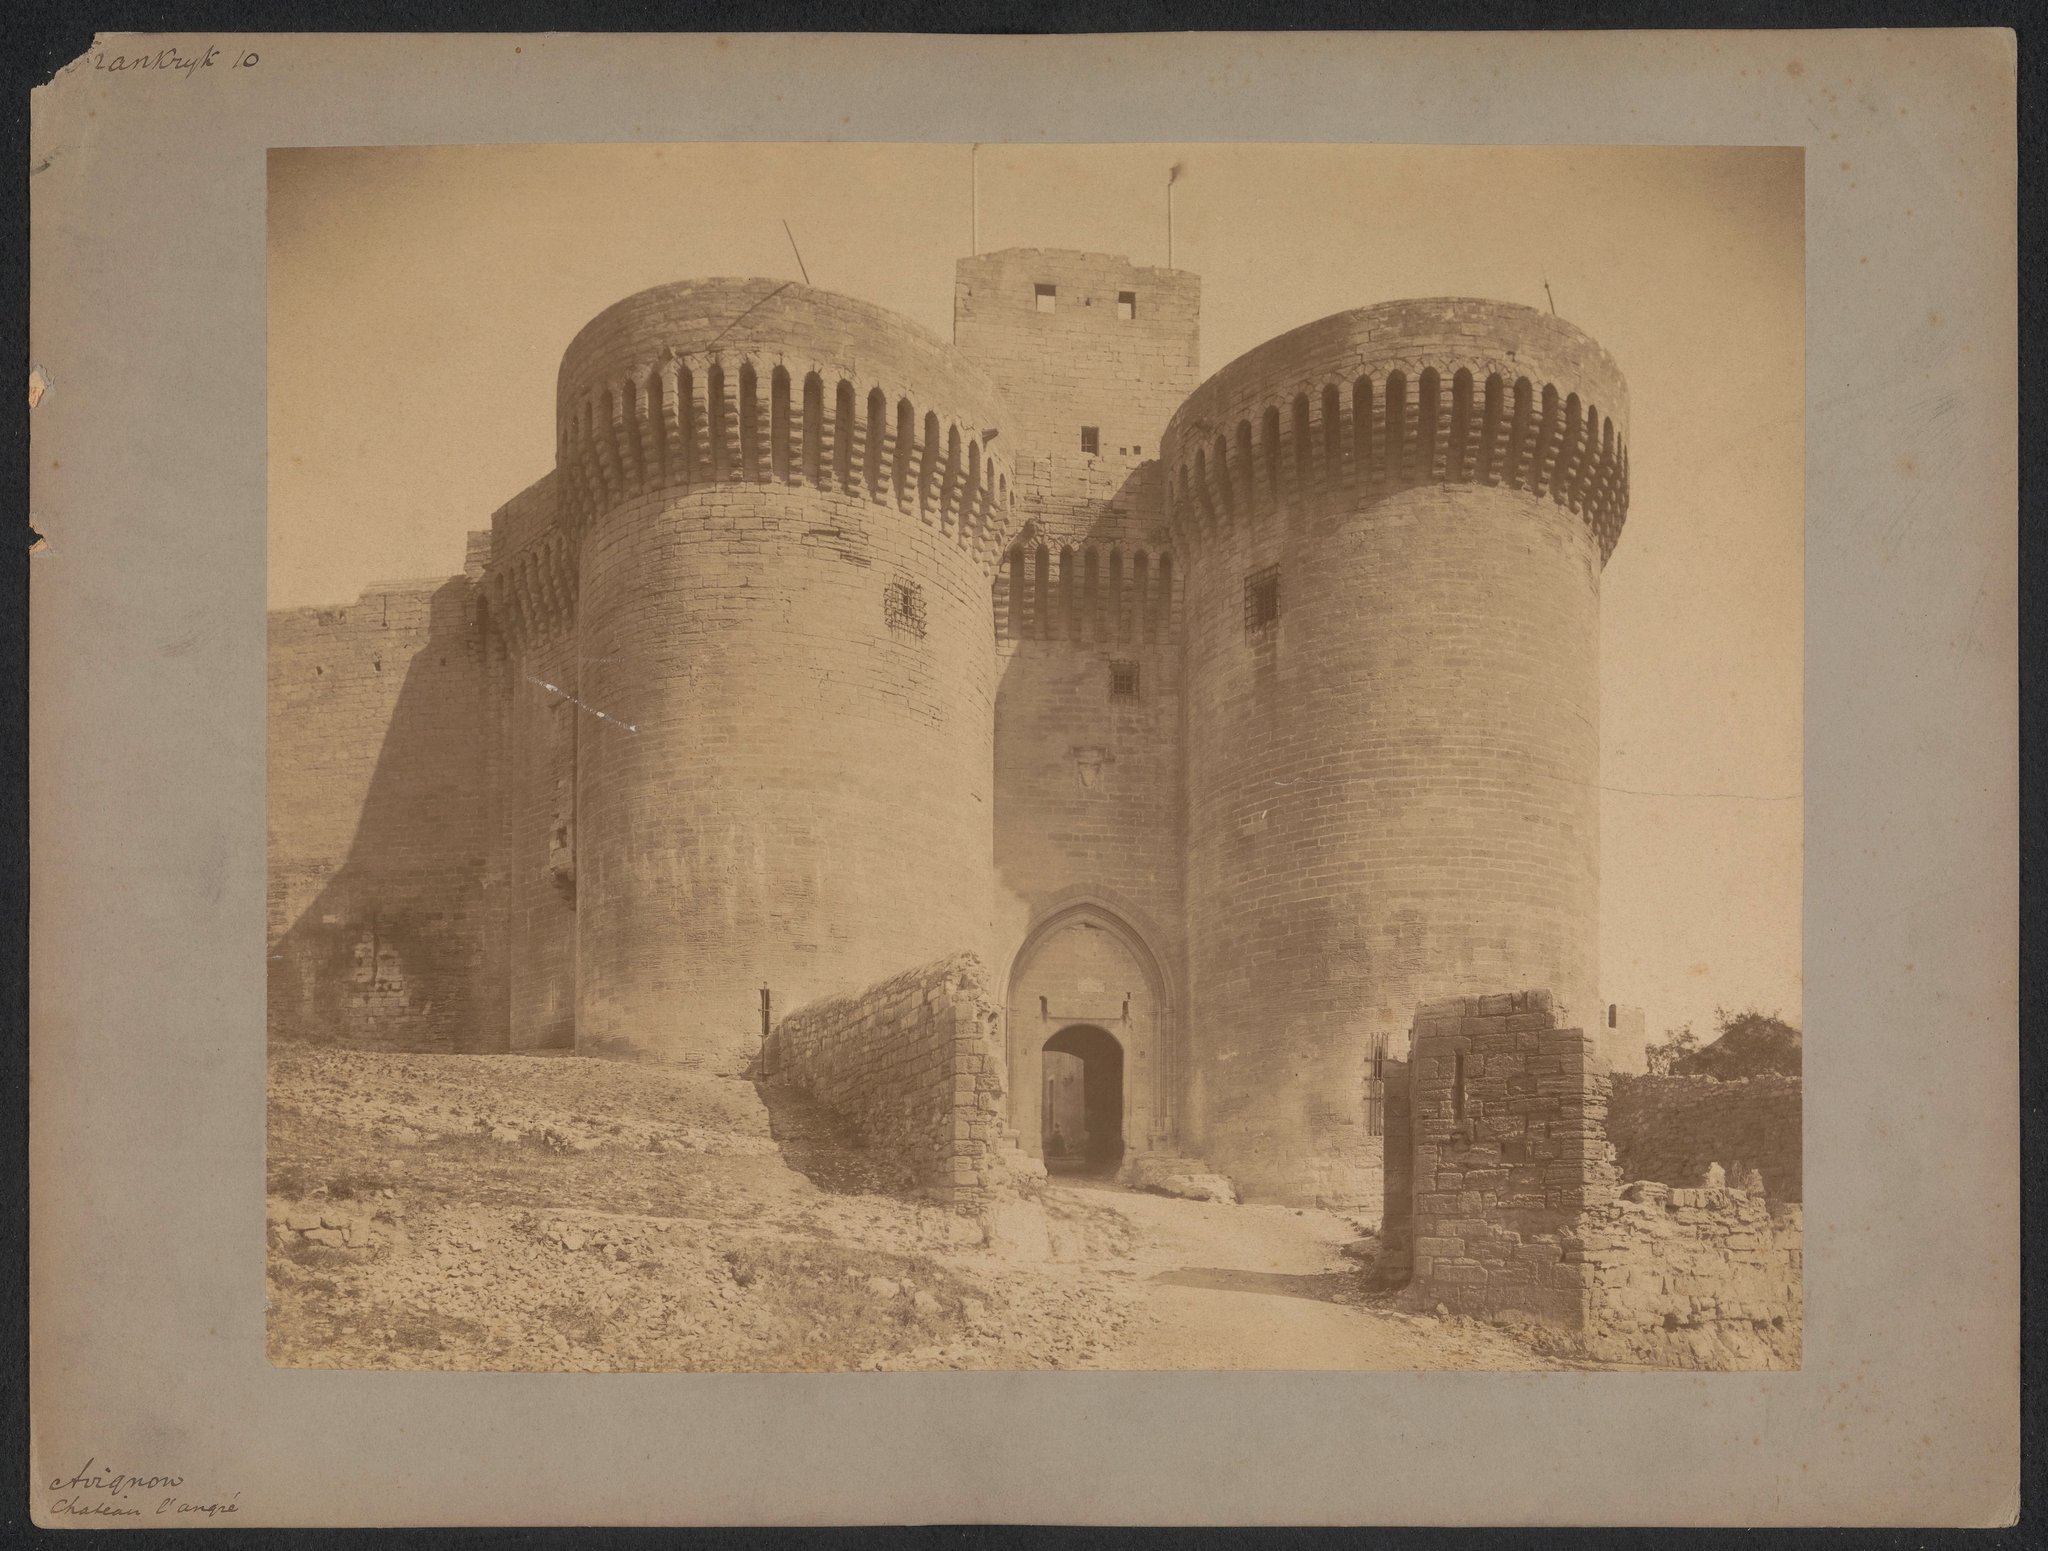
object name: photograph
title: Gezicht op fort Saint-André in de streek Villeneuve-lès-Avignon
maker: Anonymous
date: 1850-1900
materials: cardboard, photographic support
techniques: albumen print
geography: villeneuve-lès-avignon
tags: castle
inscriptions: annotation: ‘Frankrijk 10’, collector's mark: ‘RIJKS NORMAALSCHOOL voor T[EEKENONDERWIJZERS] AMSTERDAM’, annotation: ‘Avignon/ Chateau l'angré’, annotation: ‘[...]/ omstreken van Avignon/ Poort van het kasteel/ L'angré’